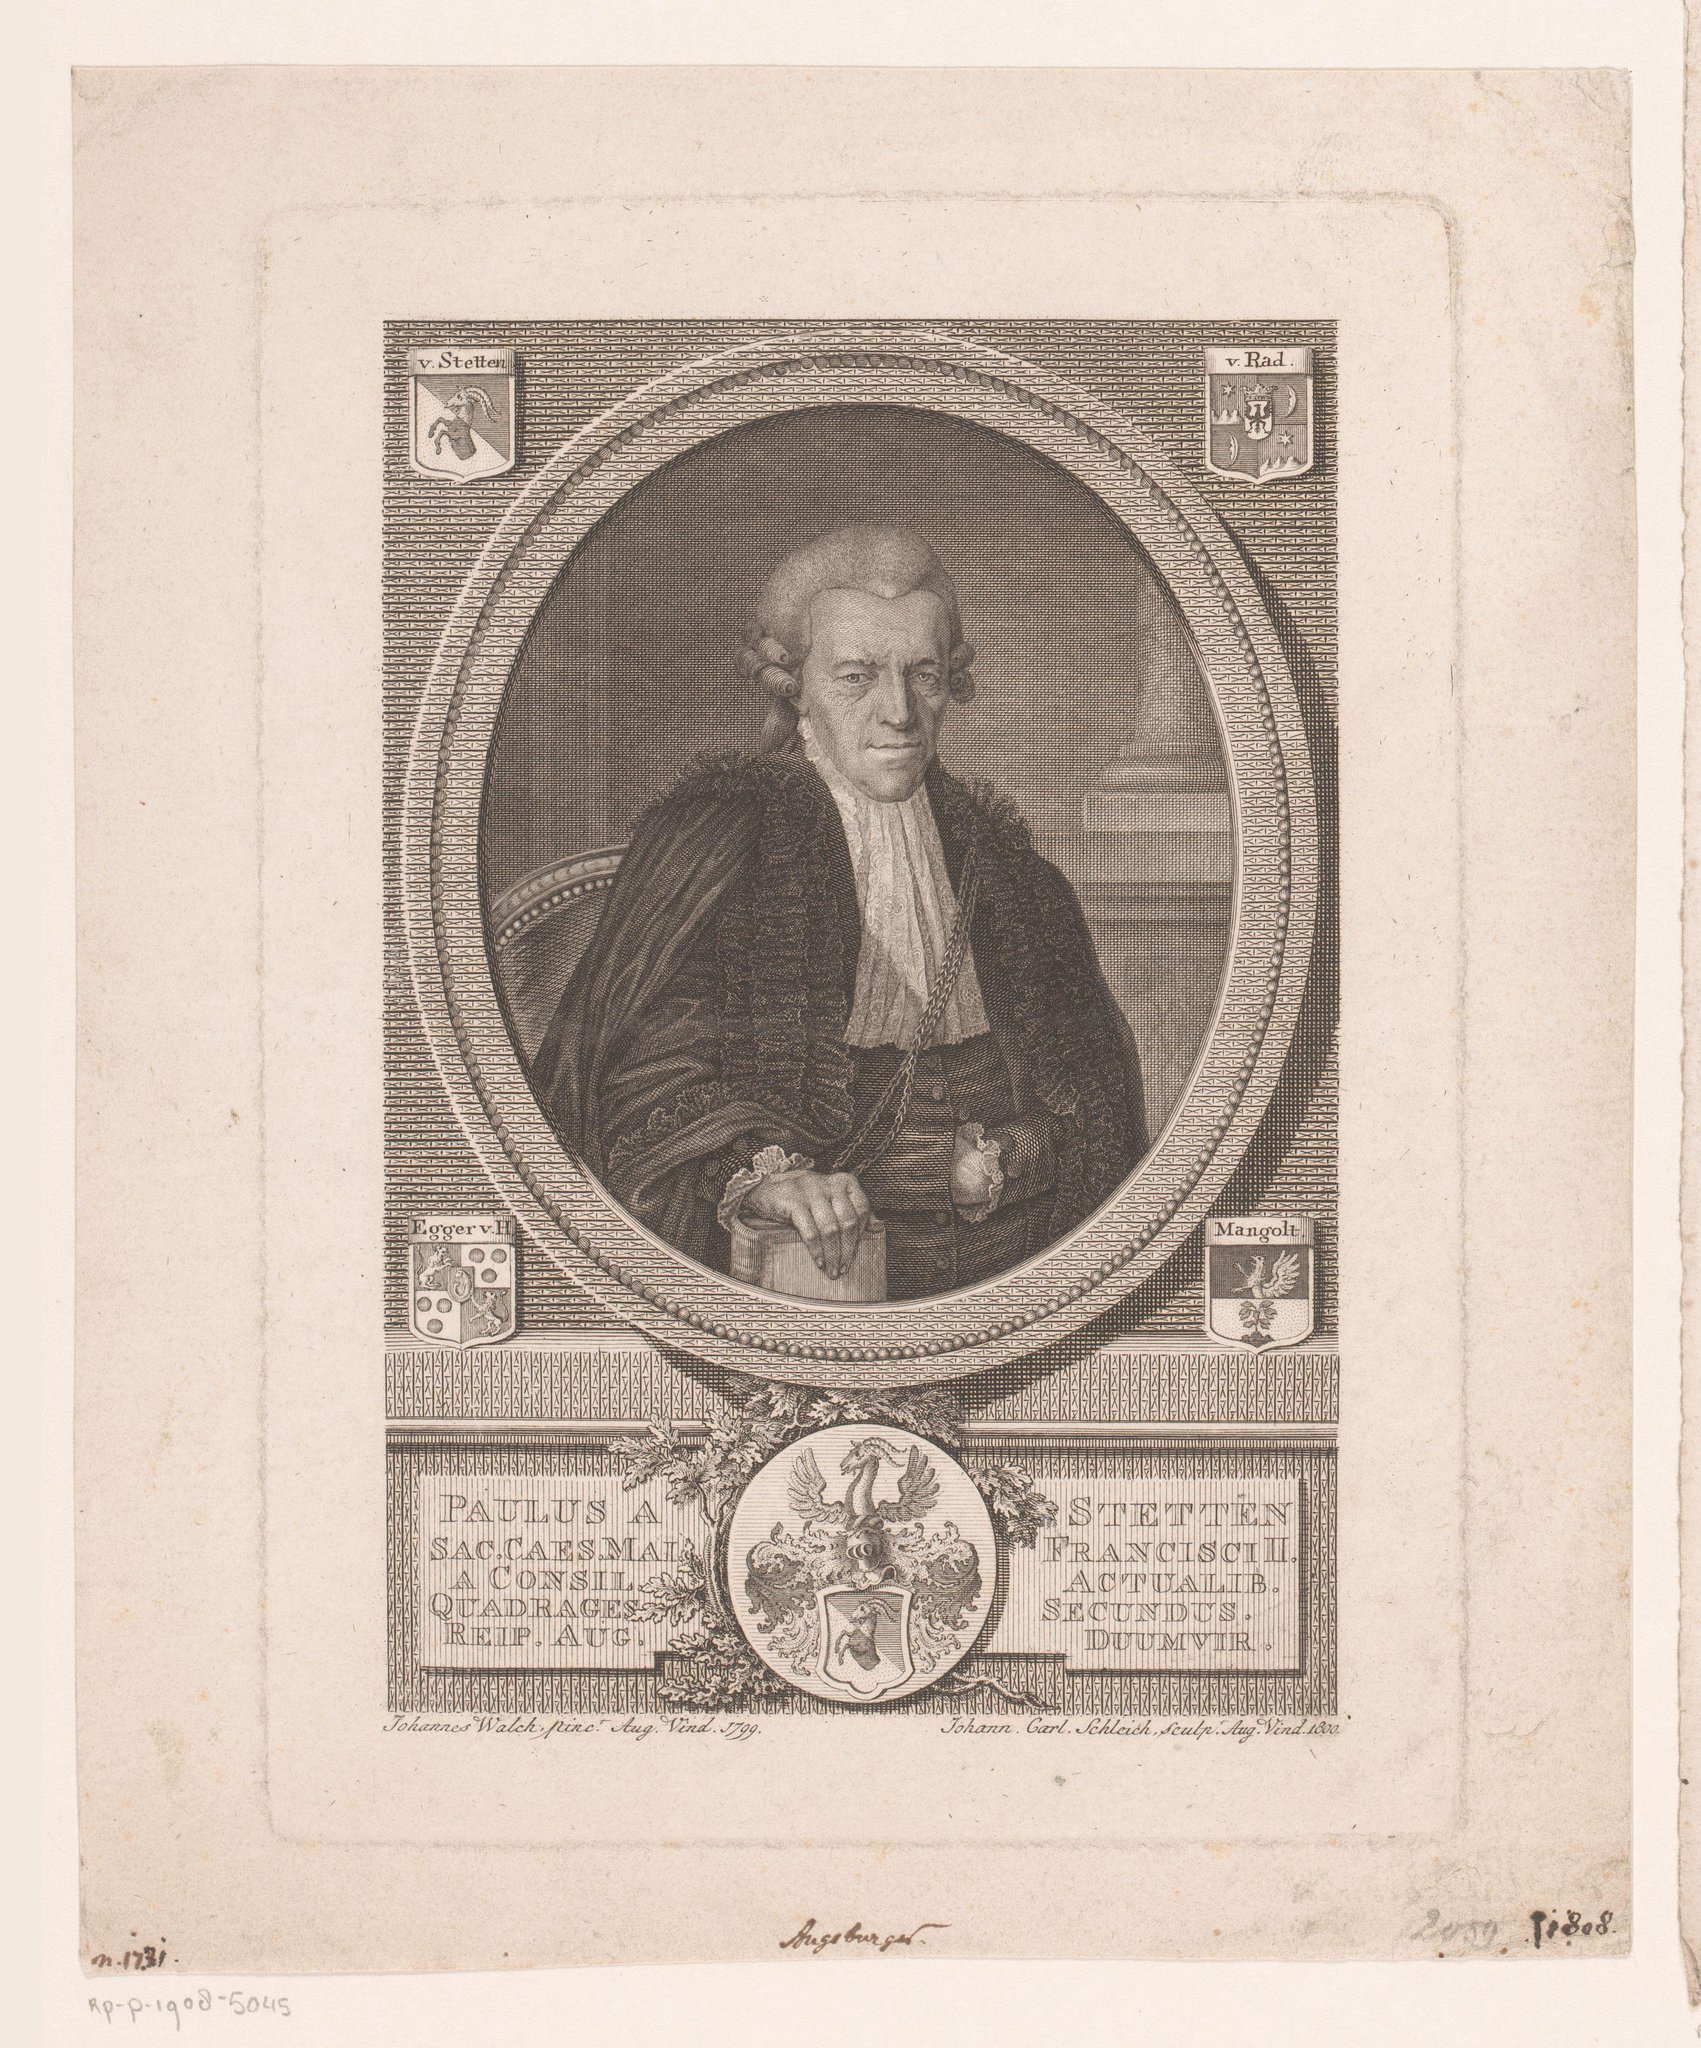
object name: print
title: Portret van Paul von Stetten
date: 1800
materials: paper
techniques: engraving, etching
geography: augsburg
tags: historical persons, armorial bearing, heraldry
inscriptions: collector's mark: Lugt 2228